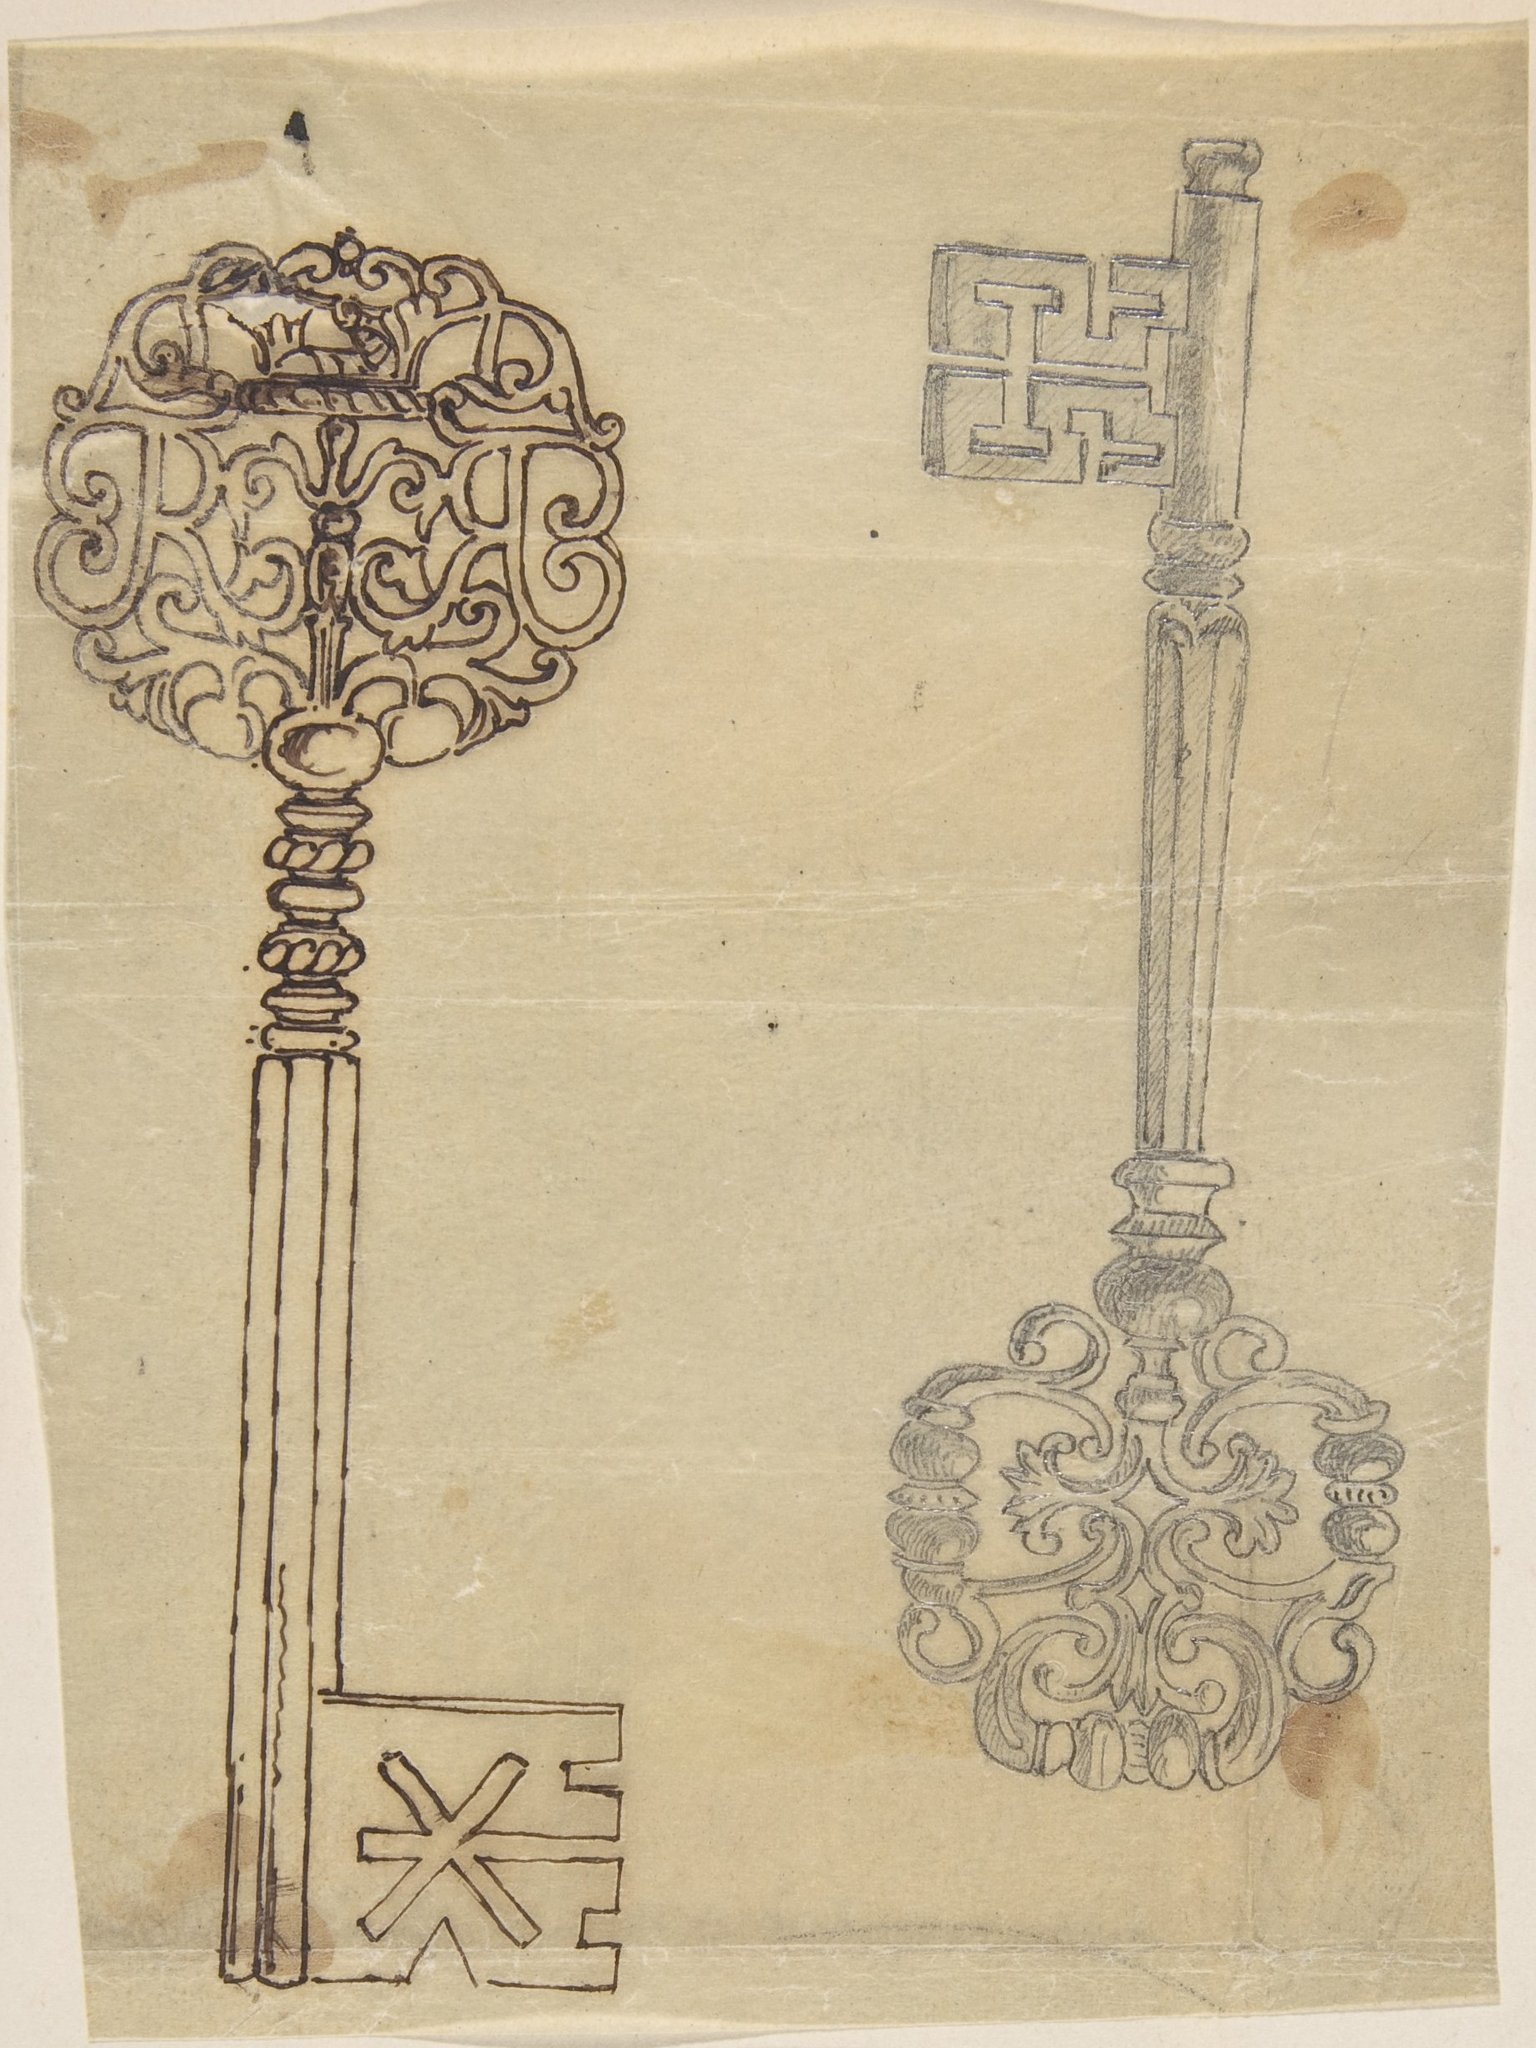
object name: drawing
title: Two Keys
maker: anonymous, british, 19th century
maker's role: artist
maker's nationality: british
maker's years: 1800-1900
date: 1851-1900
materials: graphite, ink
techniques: pen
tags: keys